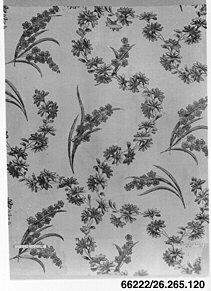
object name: piece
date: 1785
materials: cotton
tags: flowers,leaves